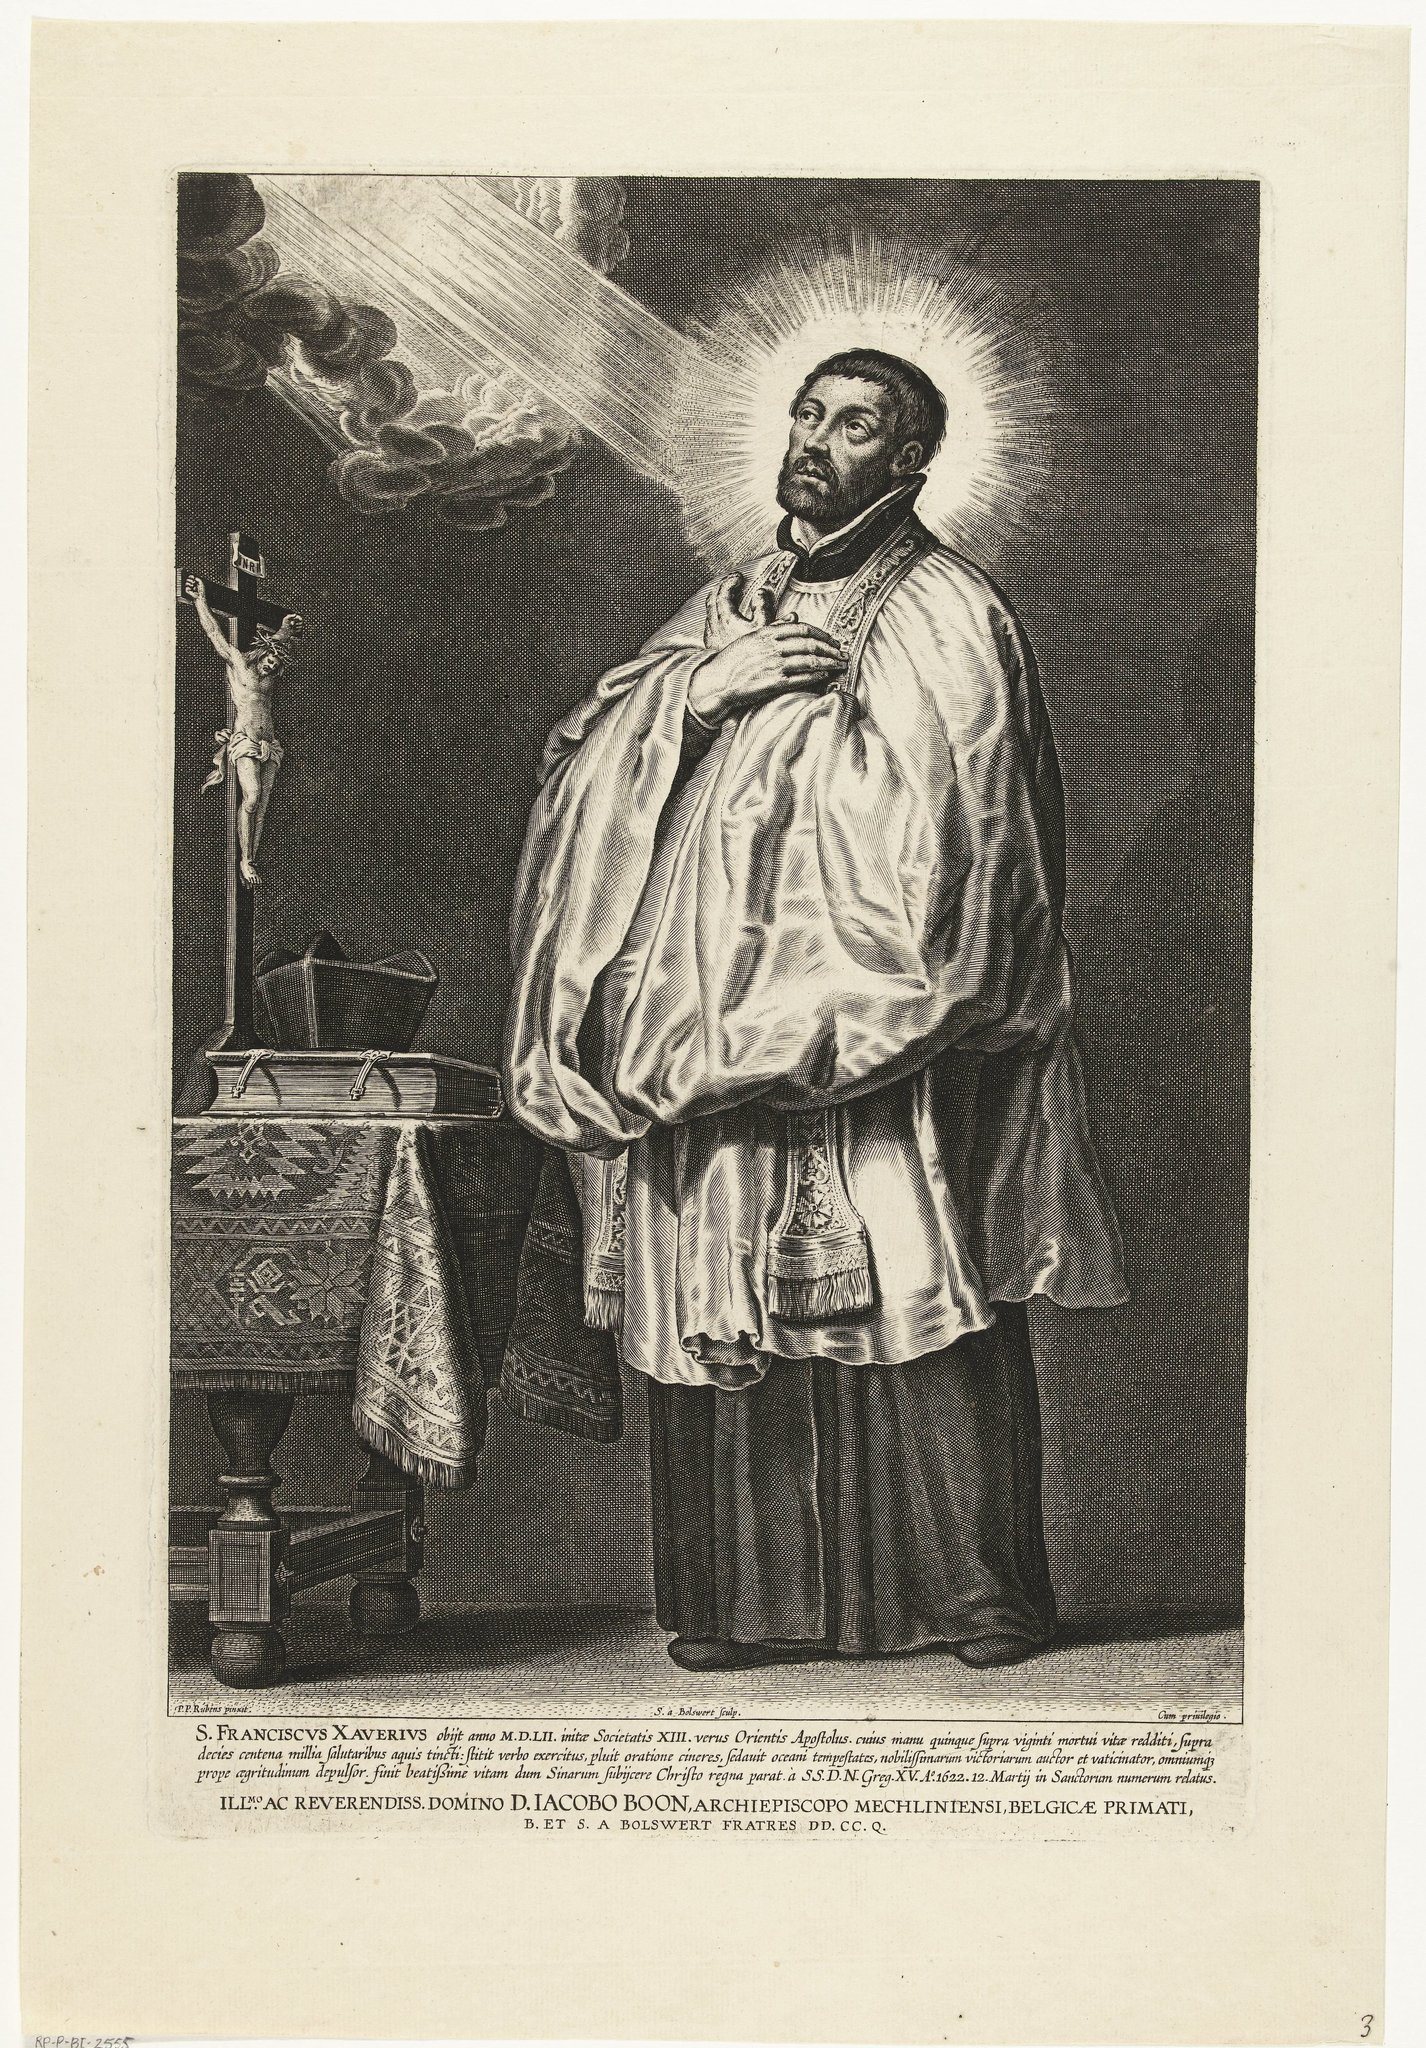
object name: print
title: Heilige Franciscus Xaverius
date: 1596-1659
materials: paper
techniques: engraving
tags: the jesuit missionary francis xavier; possible attributes: cross, crucifix, flaming heart, indian, lily, torch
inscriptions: collector's mark: Lugt 240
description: Prent naar schilderij van Peter Paul Rubens.